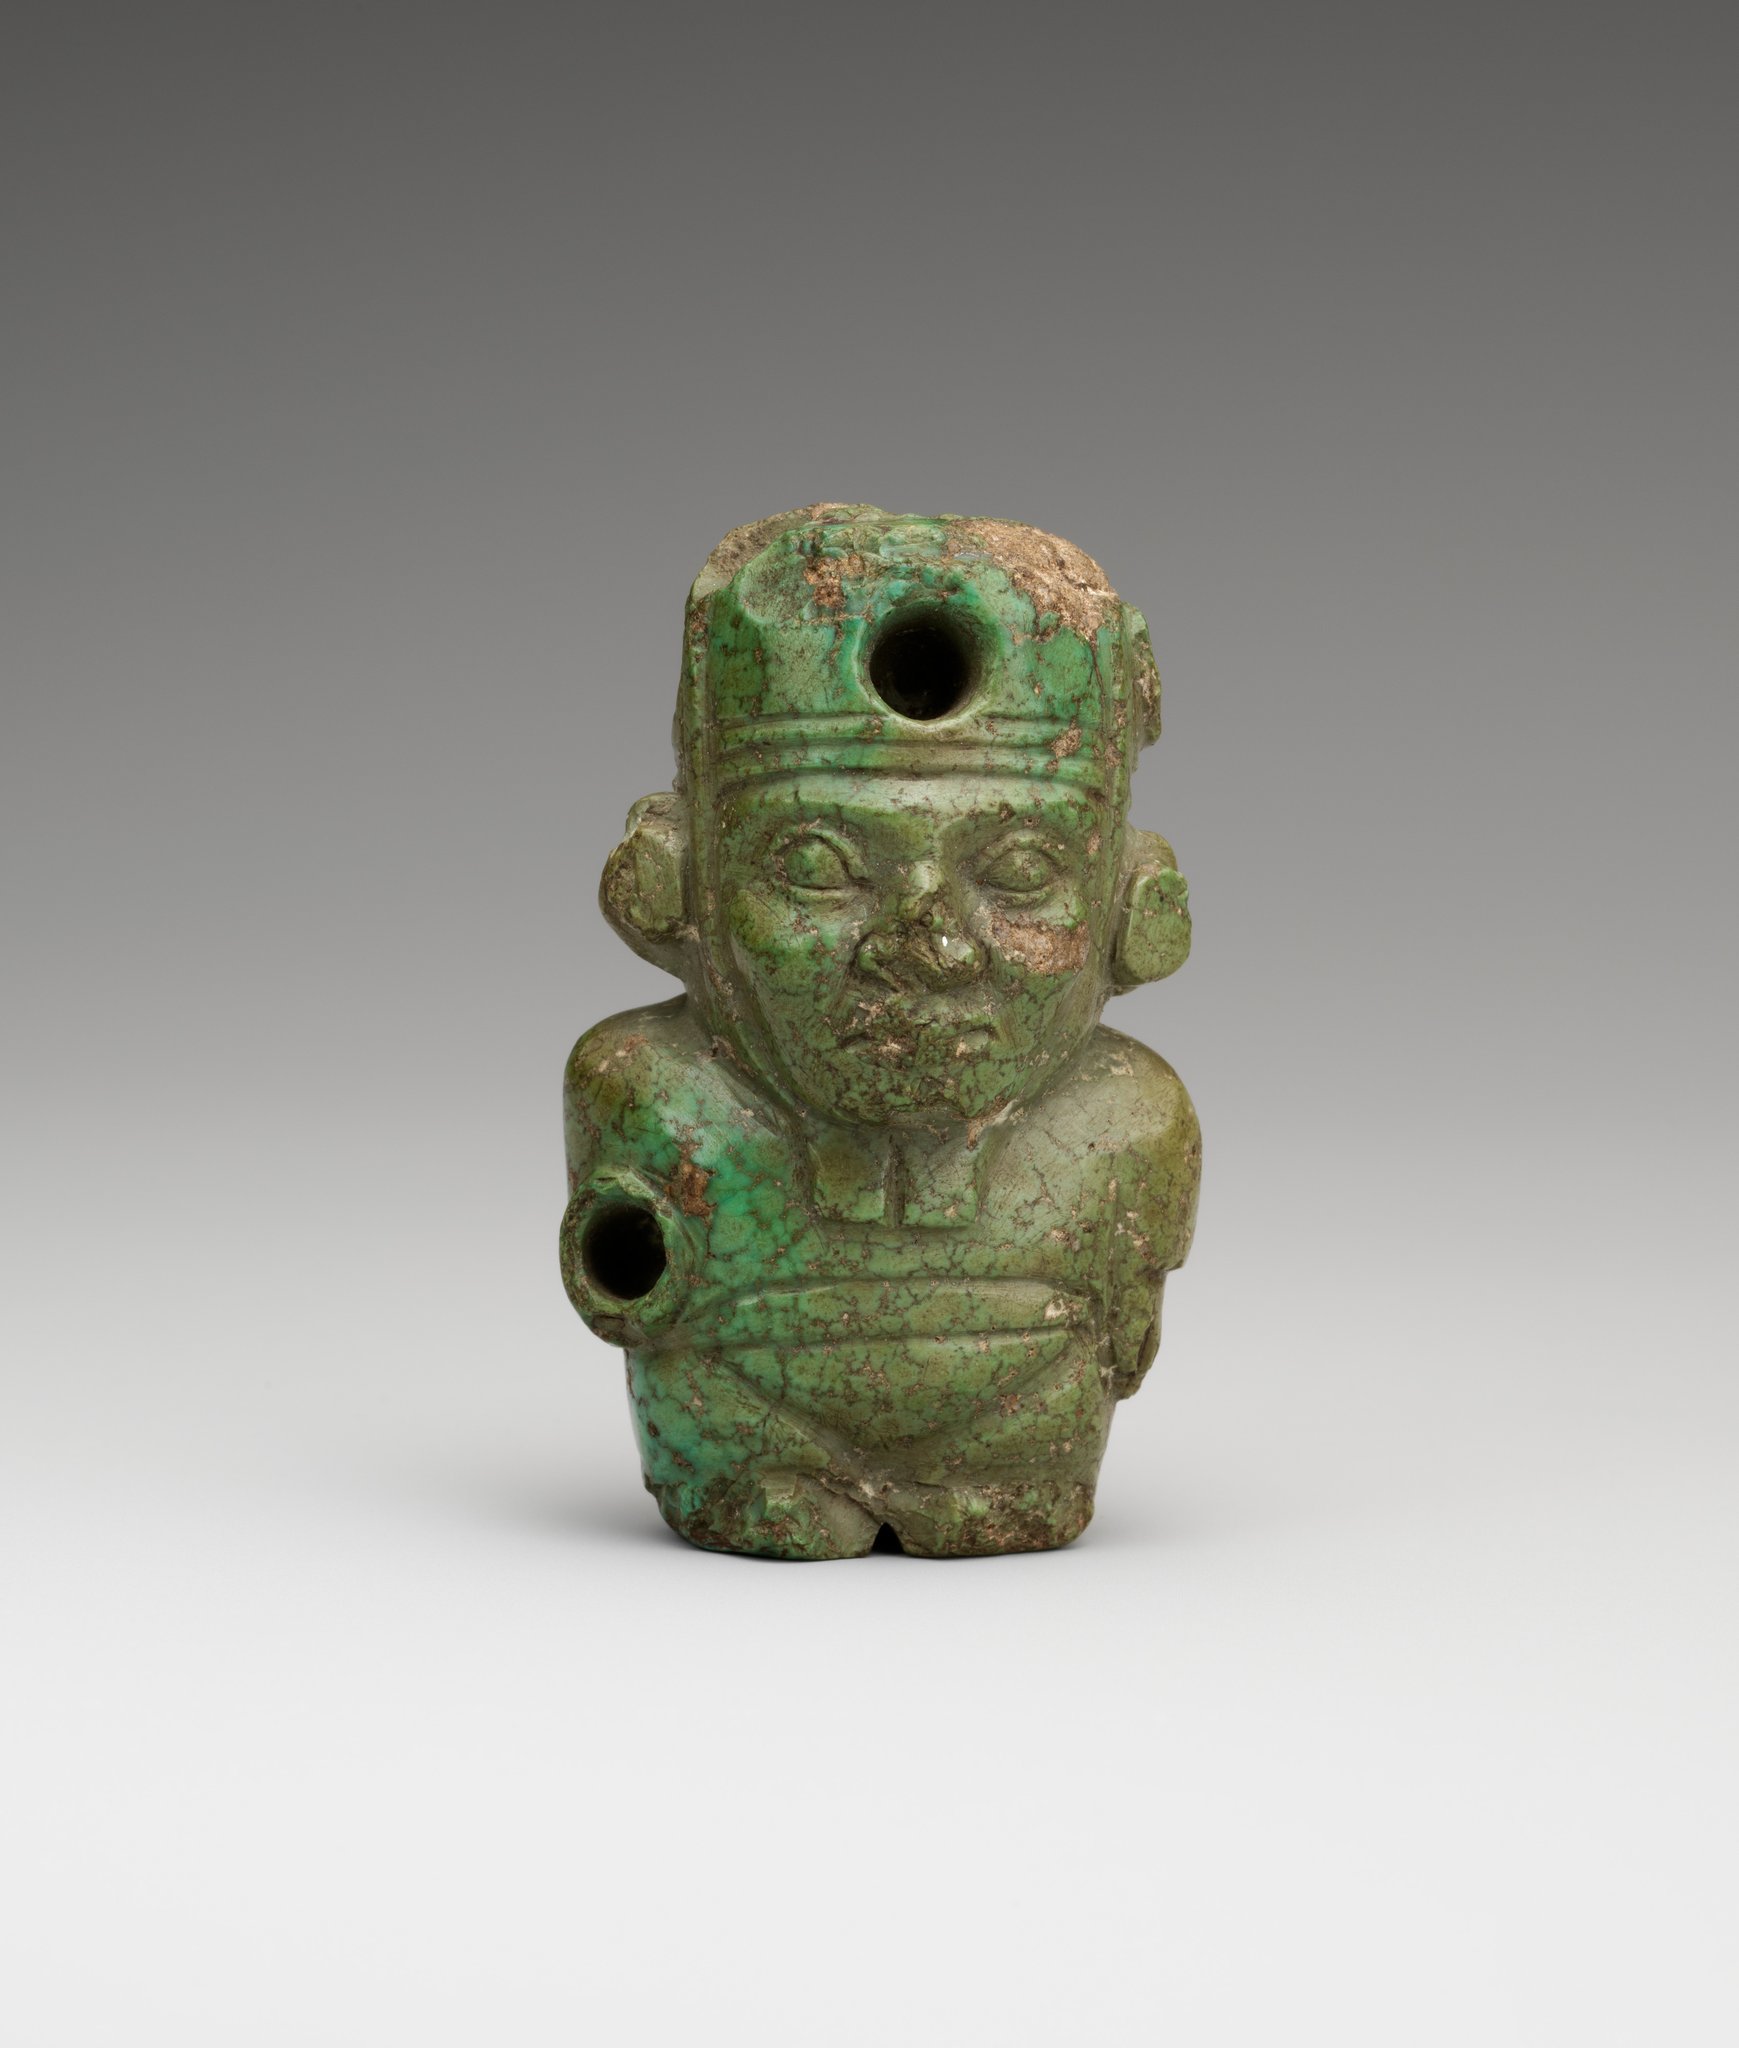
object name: figure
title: Figurine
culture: wari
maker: wari artist(s)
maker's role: artist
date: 650-800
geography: peru